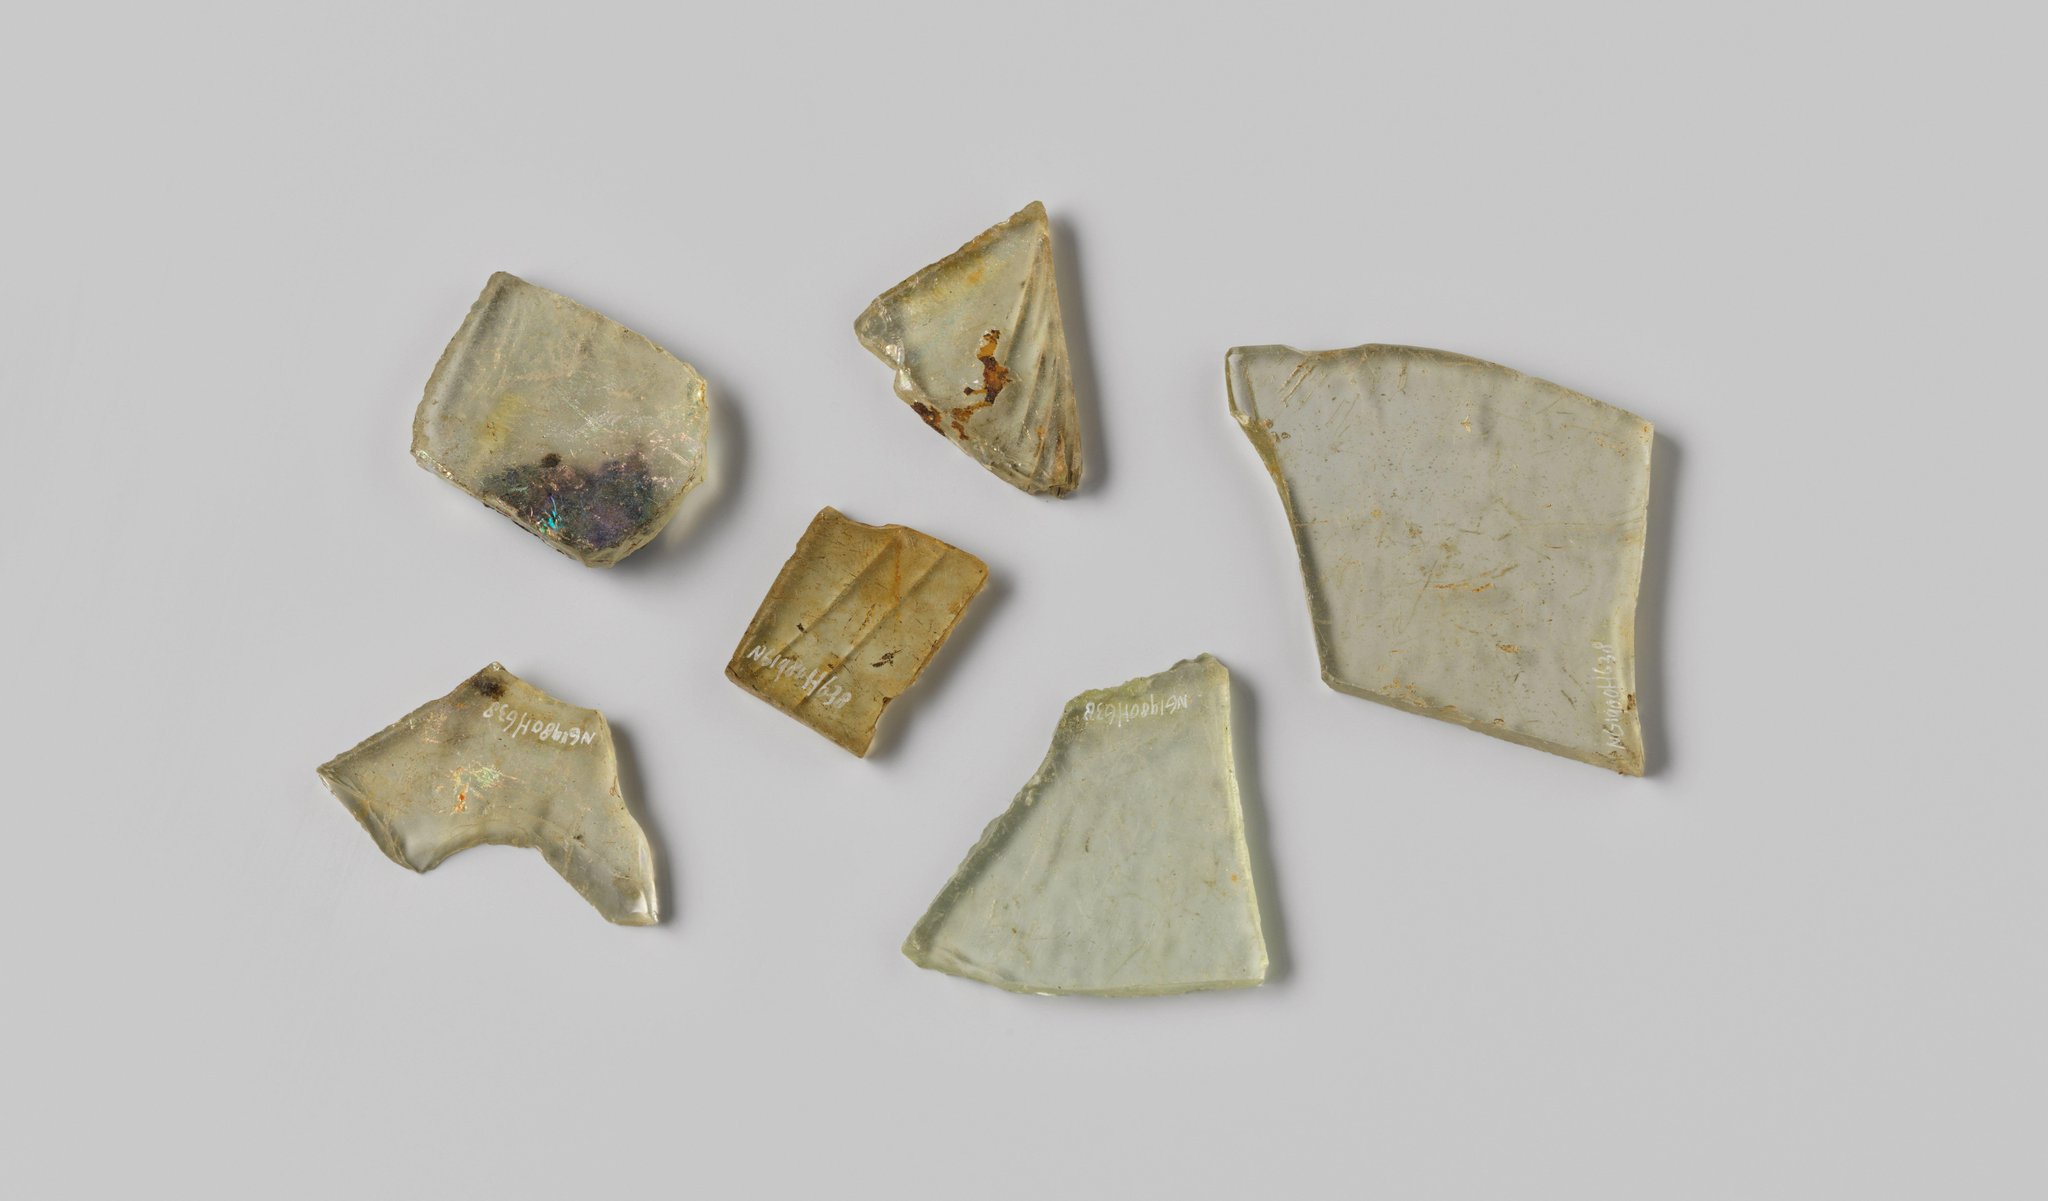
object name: light window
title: Fragmenten ruit uit het wrak van de Oost-Indiëvaarder Hollandia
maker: Anonymous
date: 1700-1743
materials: glass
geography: netherlands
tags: verenigde oostindische compagnie, hollandia (schip), annet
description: Varied parts or fragments, window glass; fragm, broken, flat.